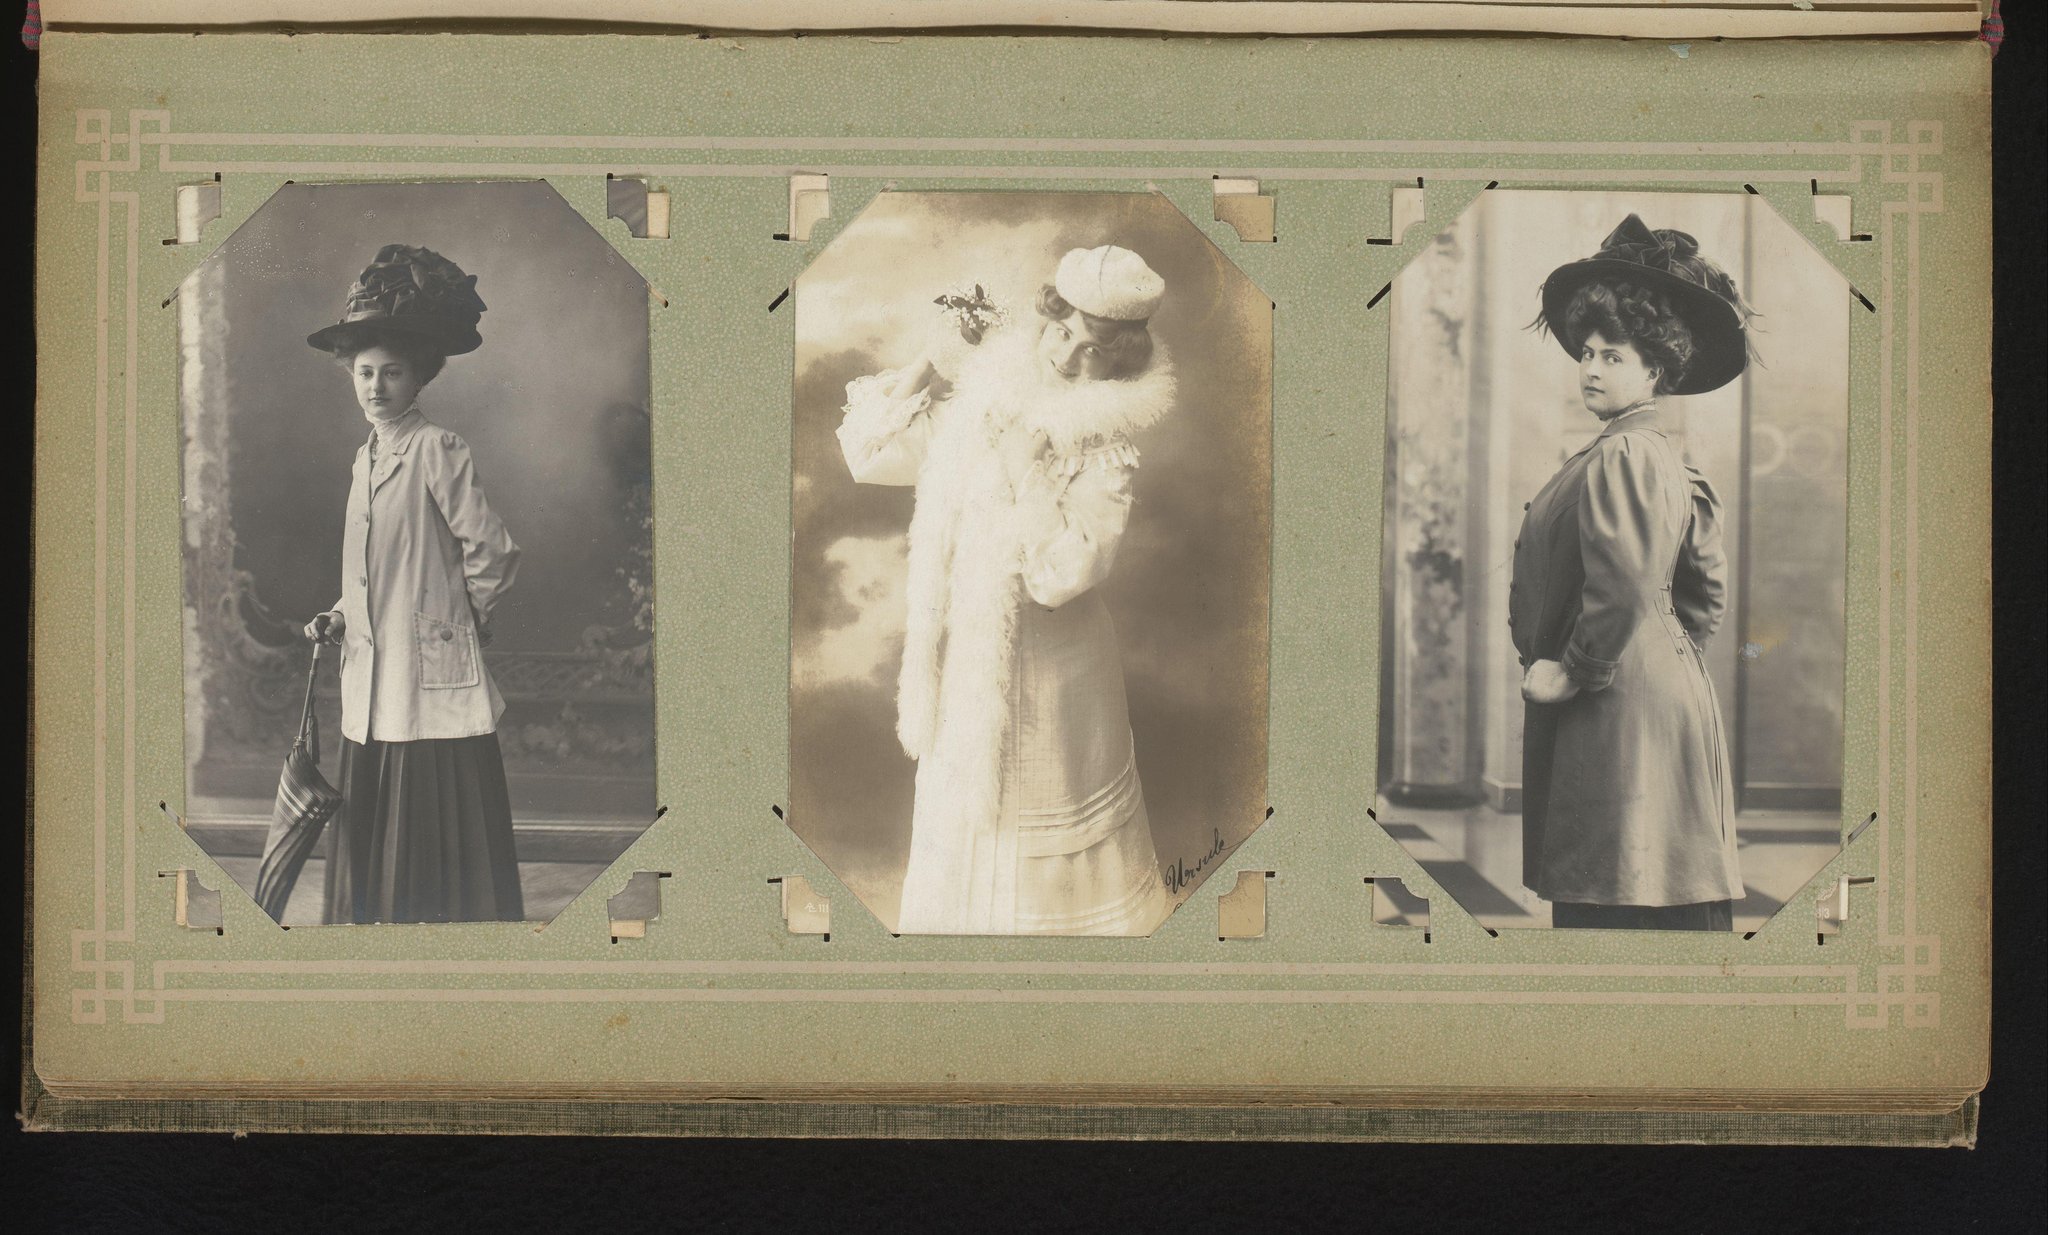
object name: ansichtkaart, prentbriefkaart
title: Drie portretten van vrouwen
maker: Anonymous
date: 1900-1930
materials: cardboard, ink, photographic support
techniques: gelatin silver print, pen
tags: historical persons - bb - woman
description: Deze foto's maken deel uit van een album.